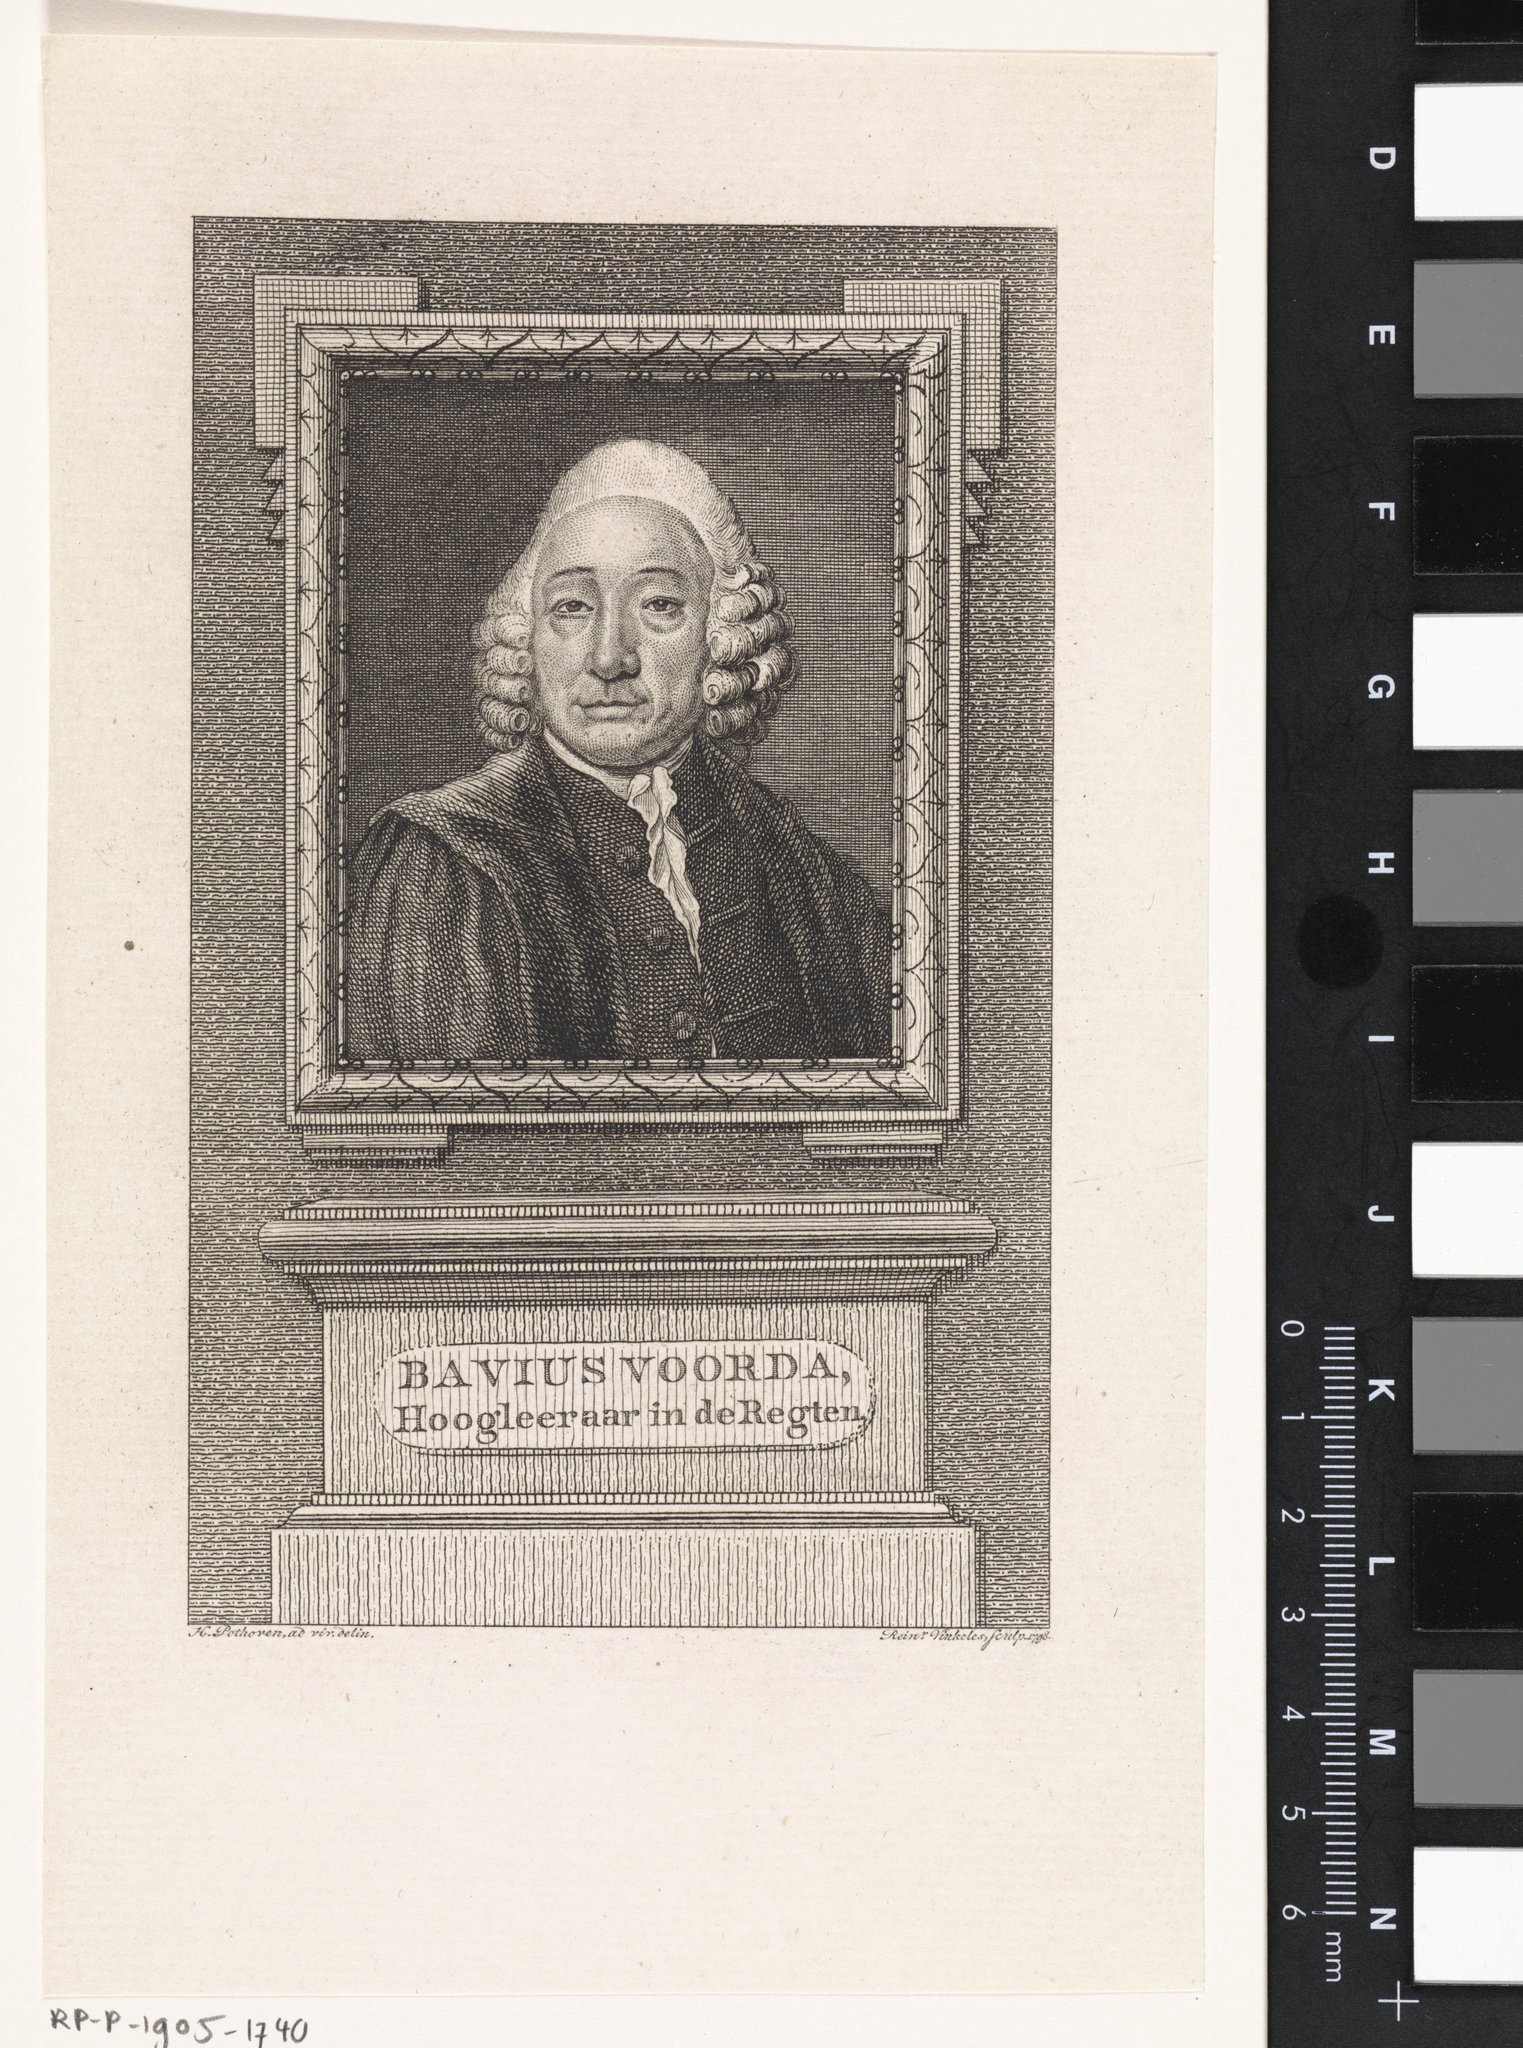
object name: print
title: Portret van Bavius Voorda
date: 1798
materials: paper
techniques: engraving, etching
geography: amsterdam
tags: leiden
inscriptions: collector's mark: Lugt 2228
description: Prent ook gebruikt als boekillustratie in: Wagenaar, Jan. Vaderlandsche historie, (...) ten vervolge van Wagenaars Vaderlandsche historie. Dl. 1-43. Amsterdam: Johannes Allart, 1786-1809.